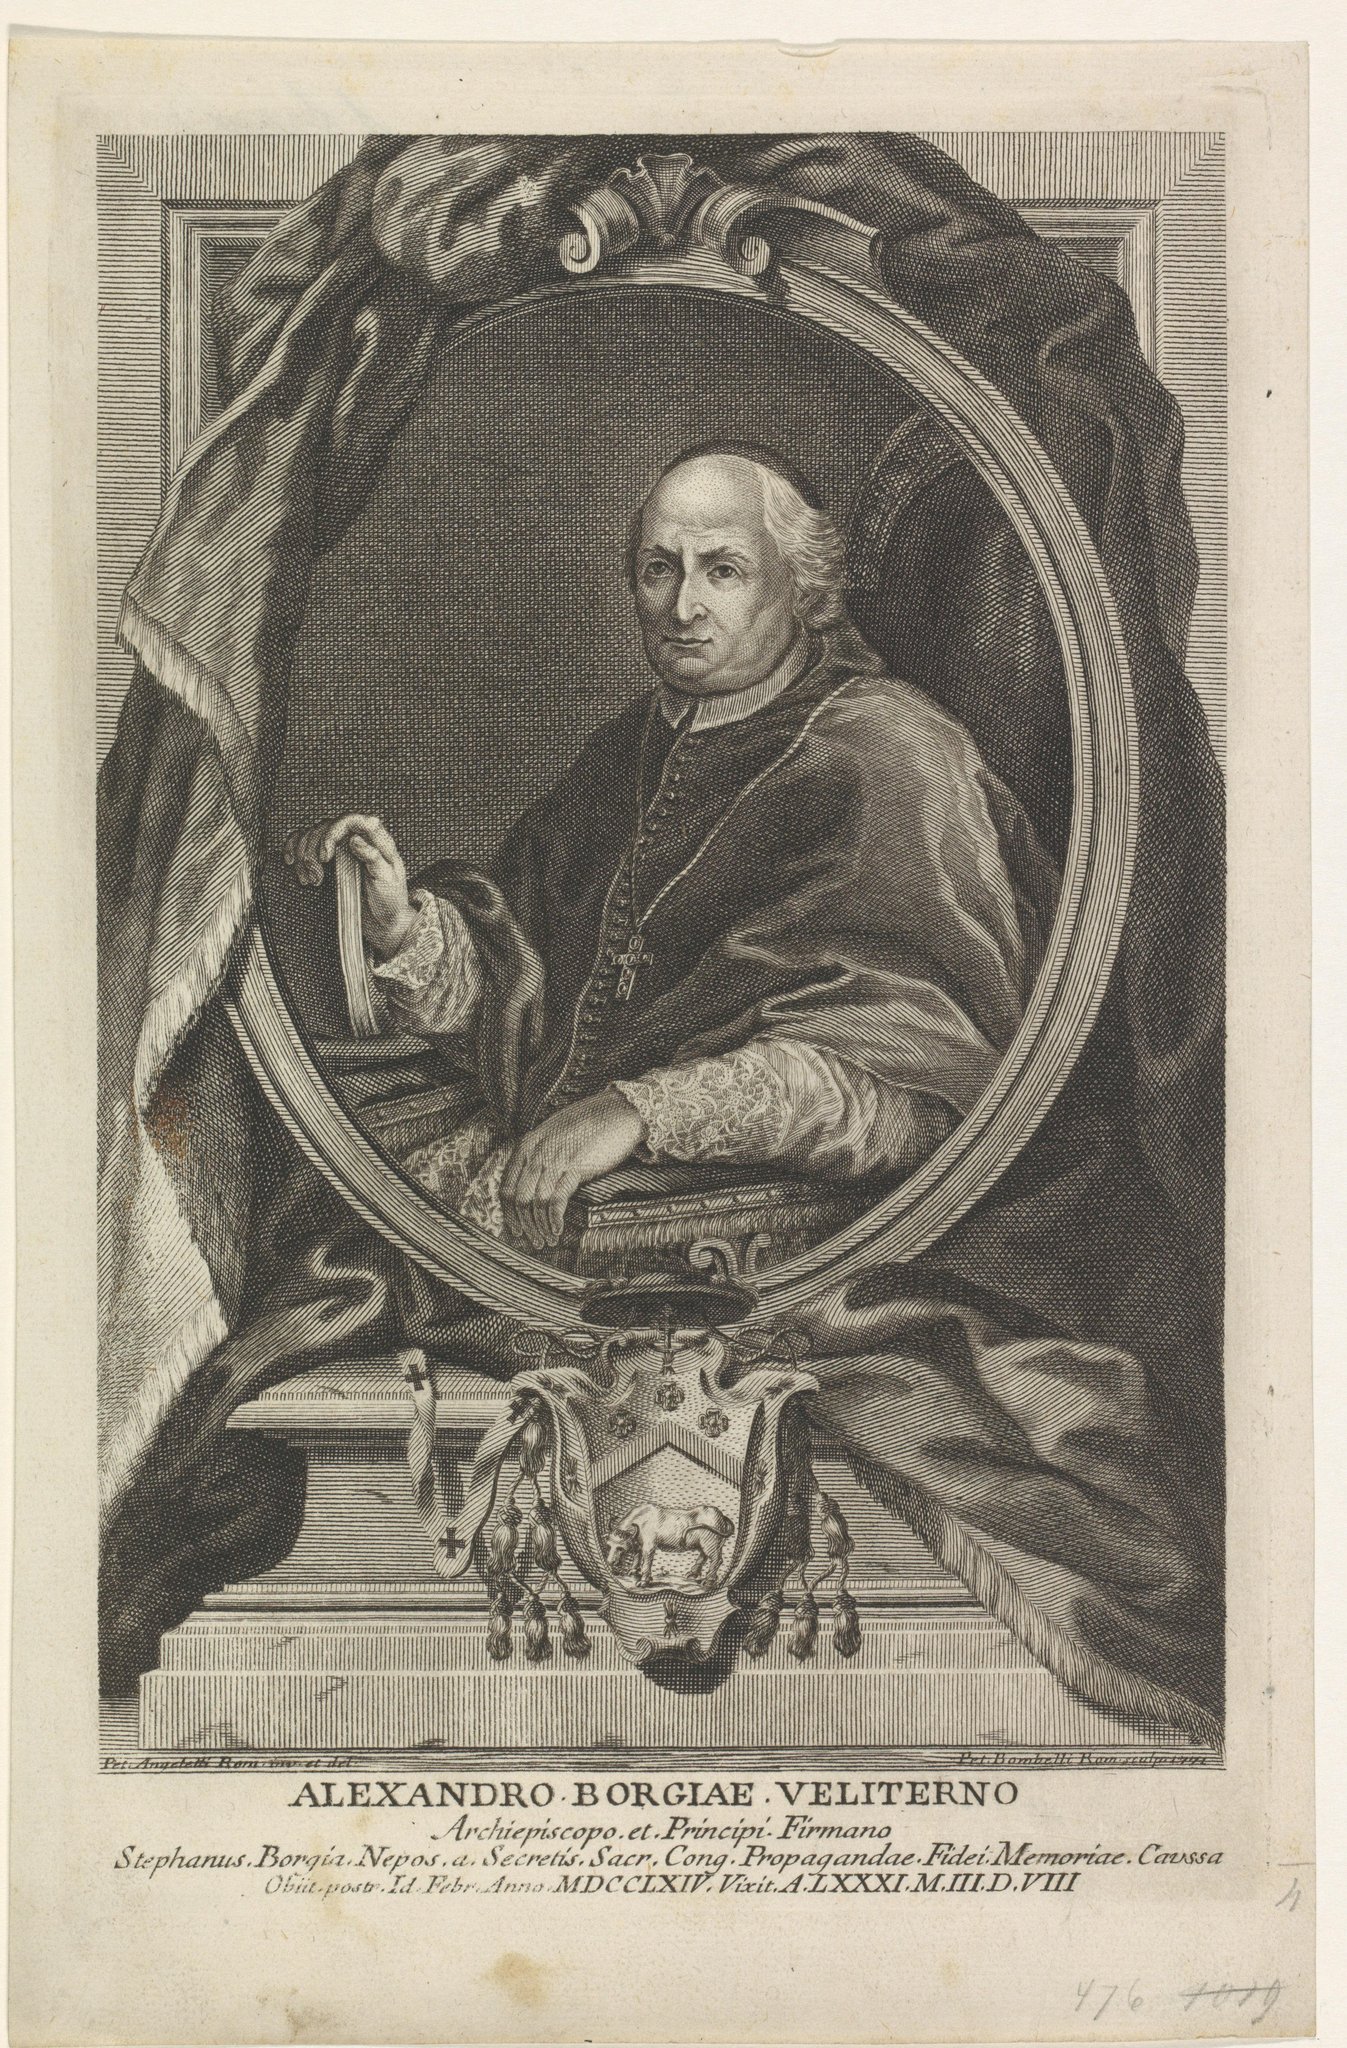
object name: print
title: Portret van Alessandro Borgia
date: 1764-1809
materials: paper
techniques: engraving, etching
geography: rome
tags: historical persons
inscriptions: collector's mark: Lugt 2228